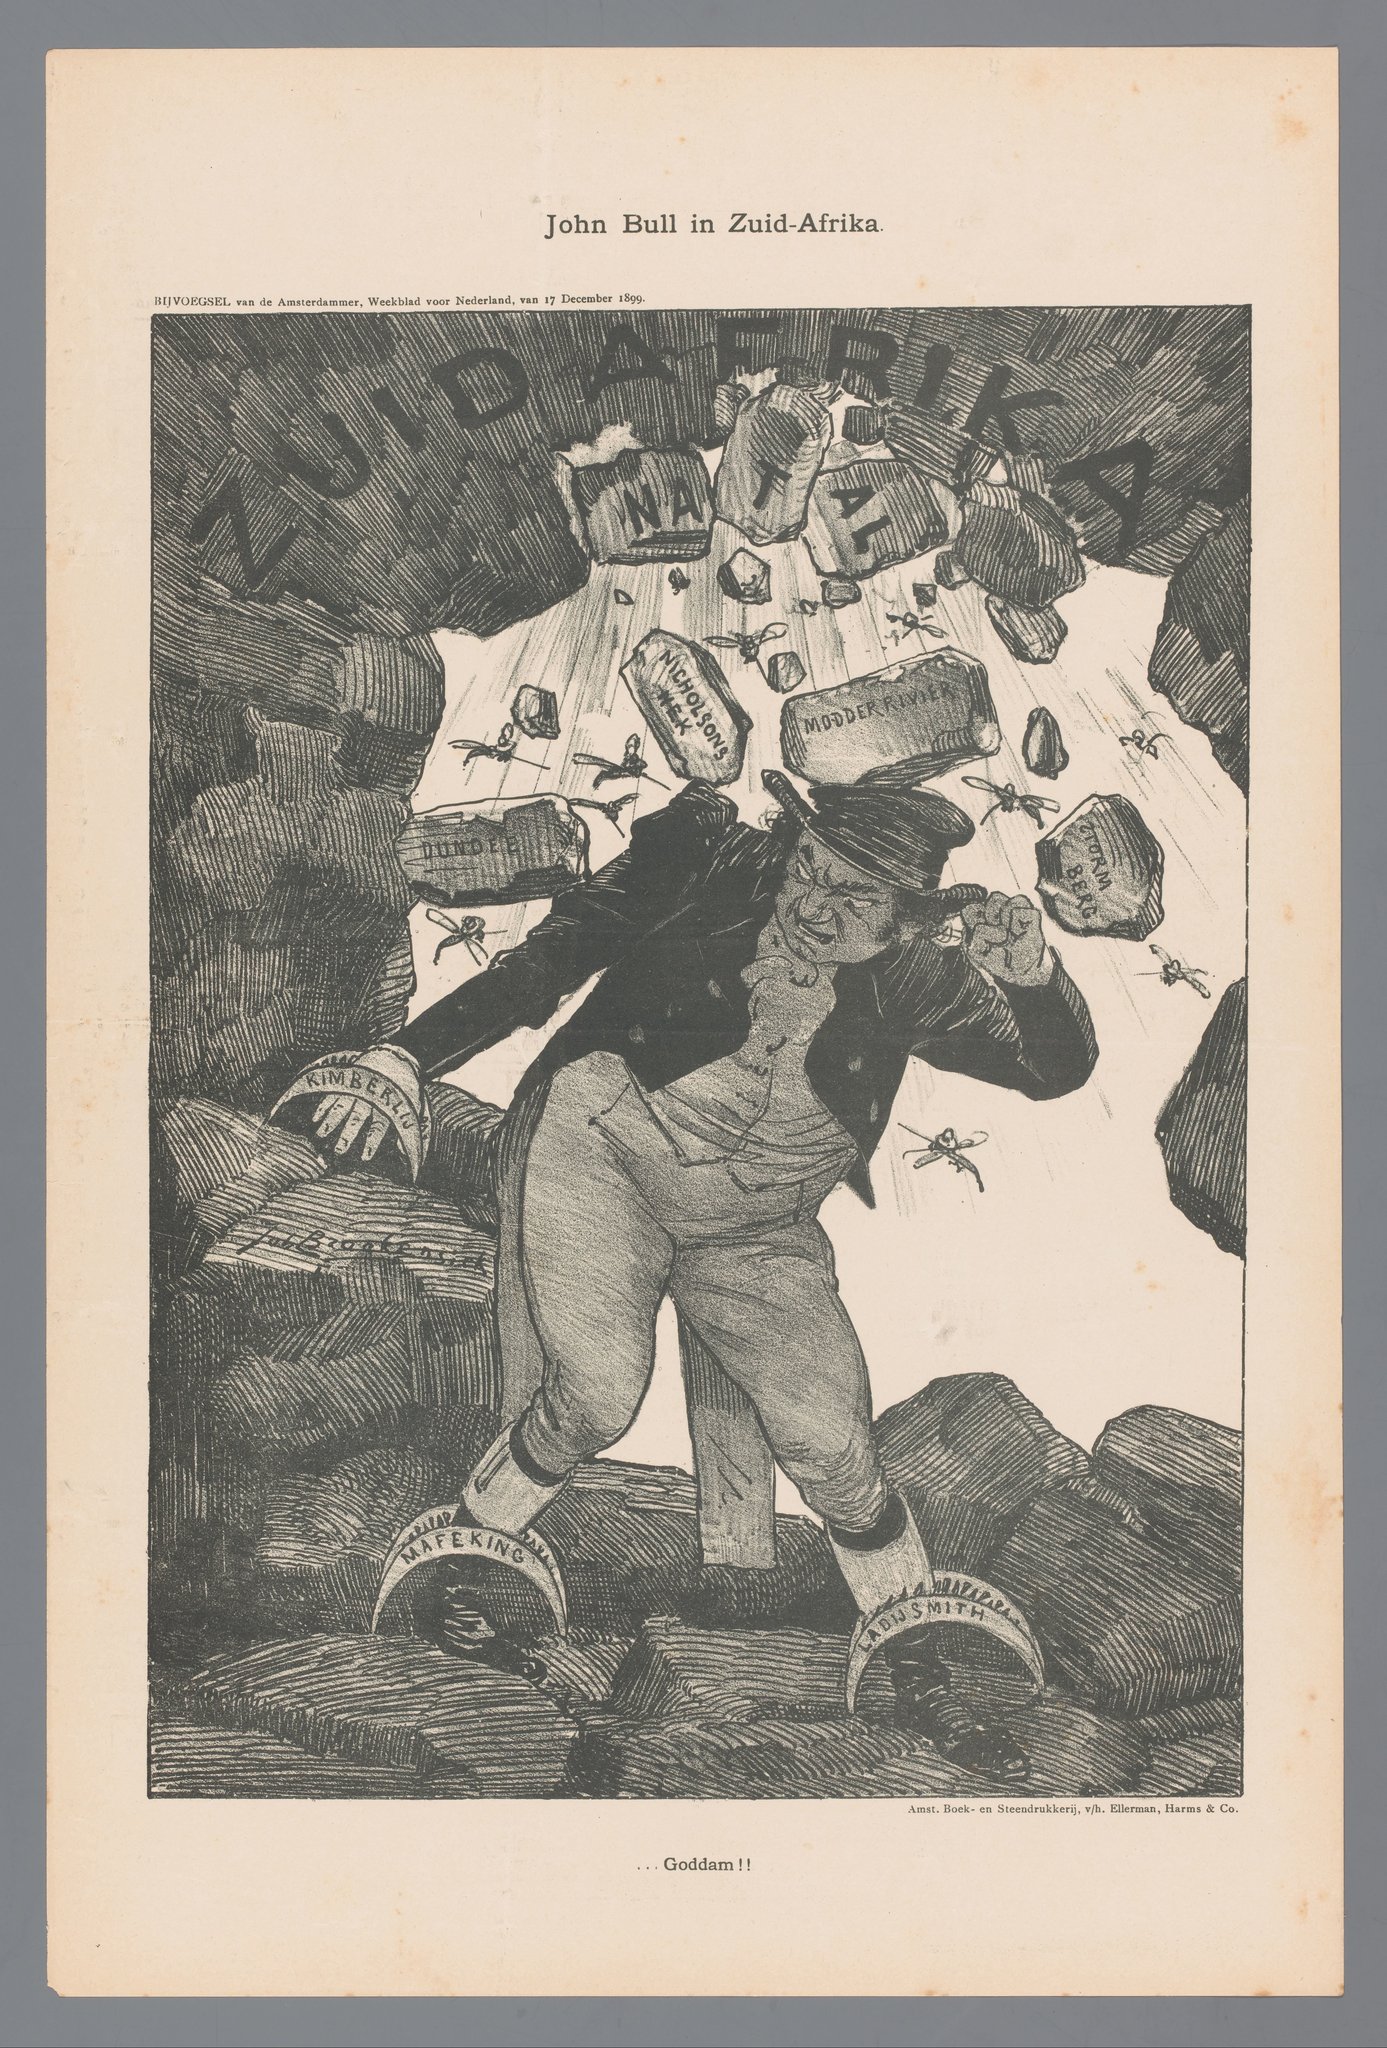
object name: cartoon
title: John Bull in Zuid-Afrika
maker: johan braakensiek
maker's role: draughtsman, print maker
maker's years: 1858-1940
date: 1899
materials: paper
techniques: lithograph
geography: amsterdam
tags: personifications of countries, nations, states, districts, etc., war, political caricatures and satires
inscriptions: date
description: Prent uit het bijvoegsel van: De Amsterdammer. Weekblad voor Nederland, 17 december 1899.